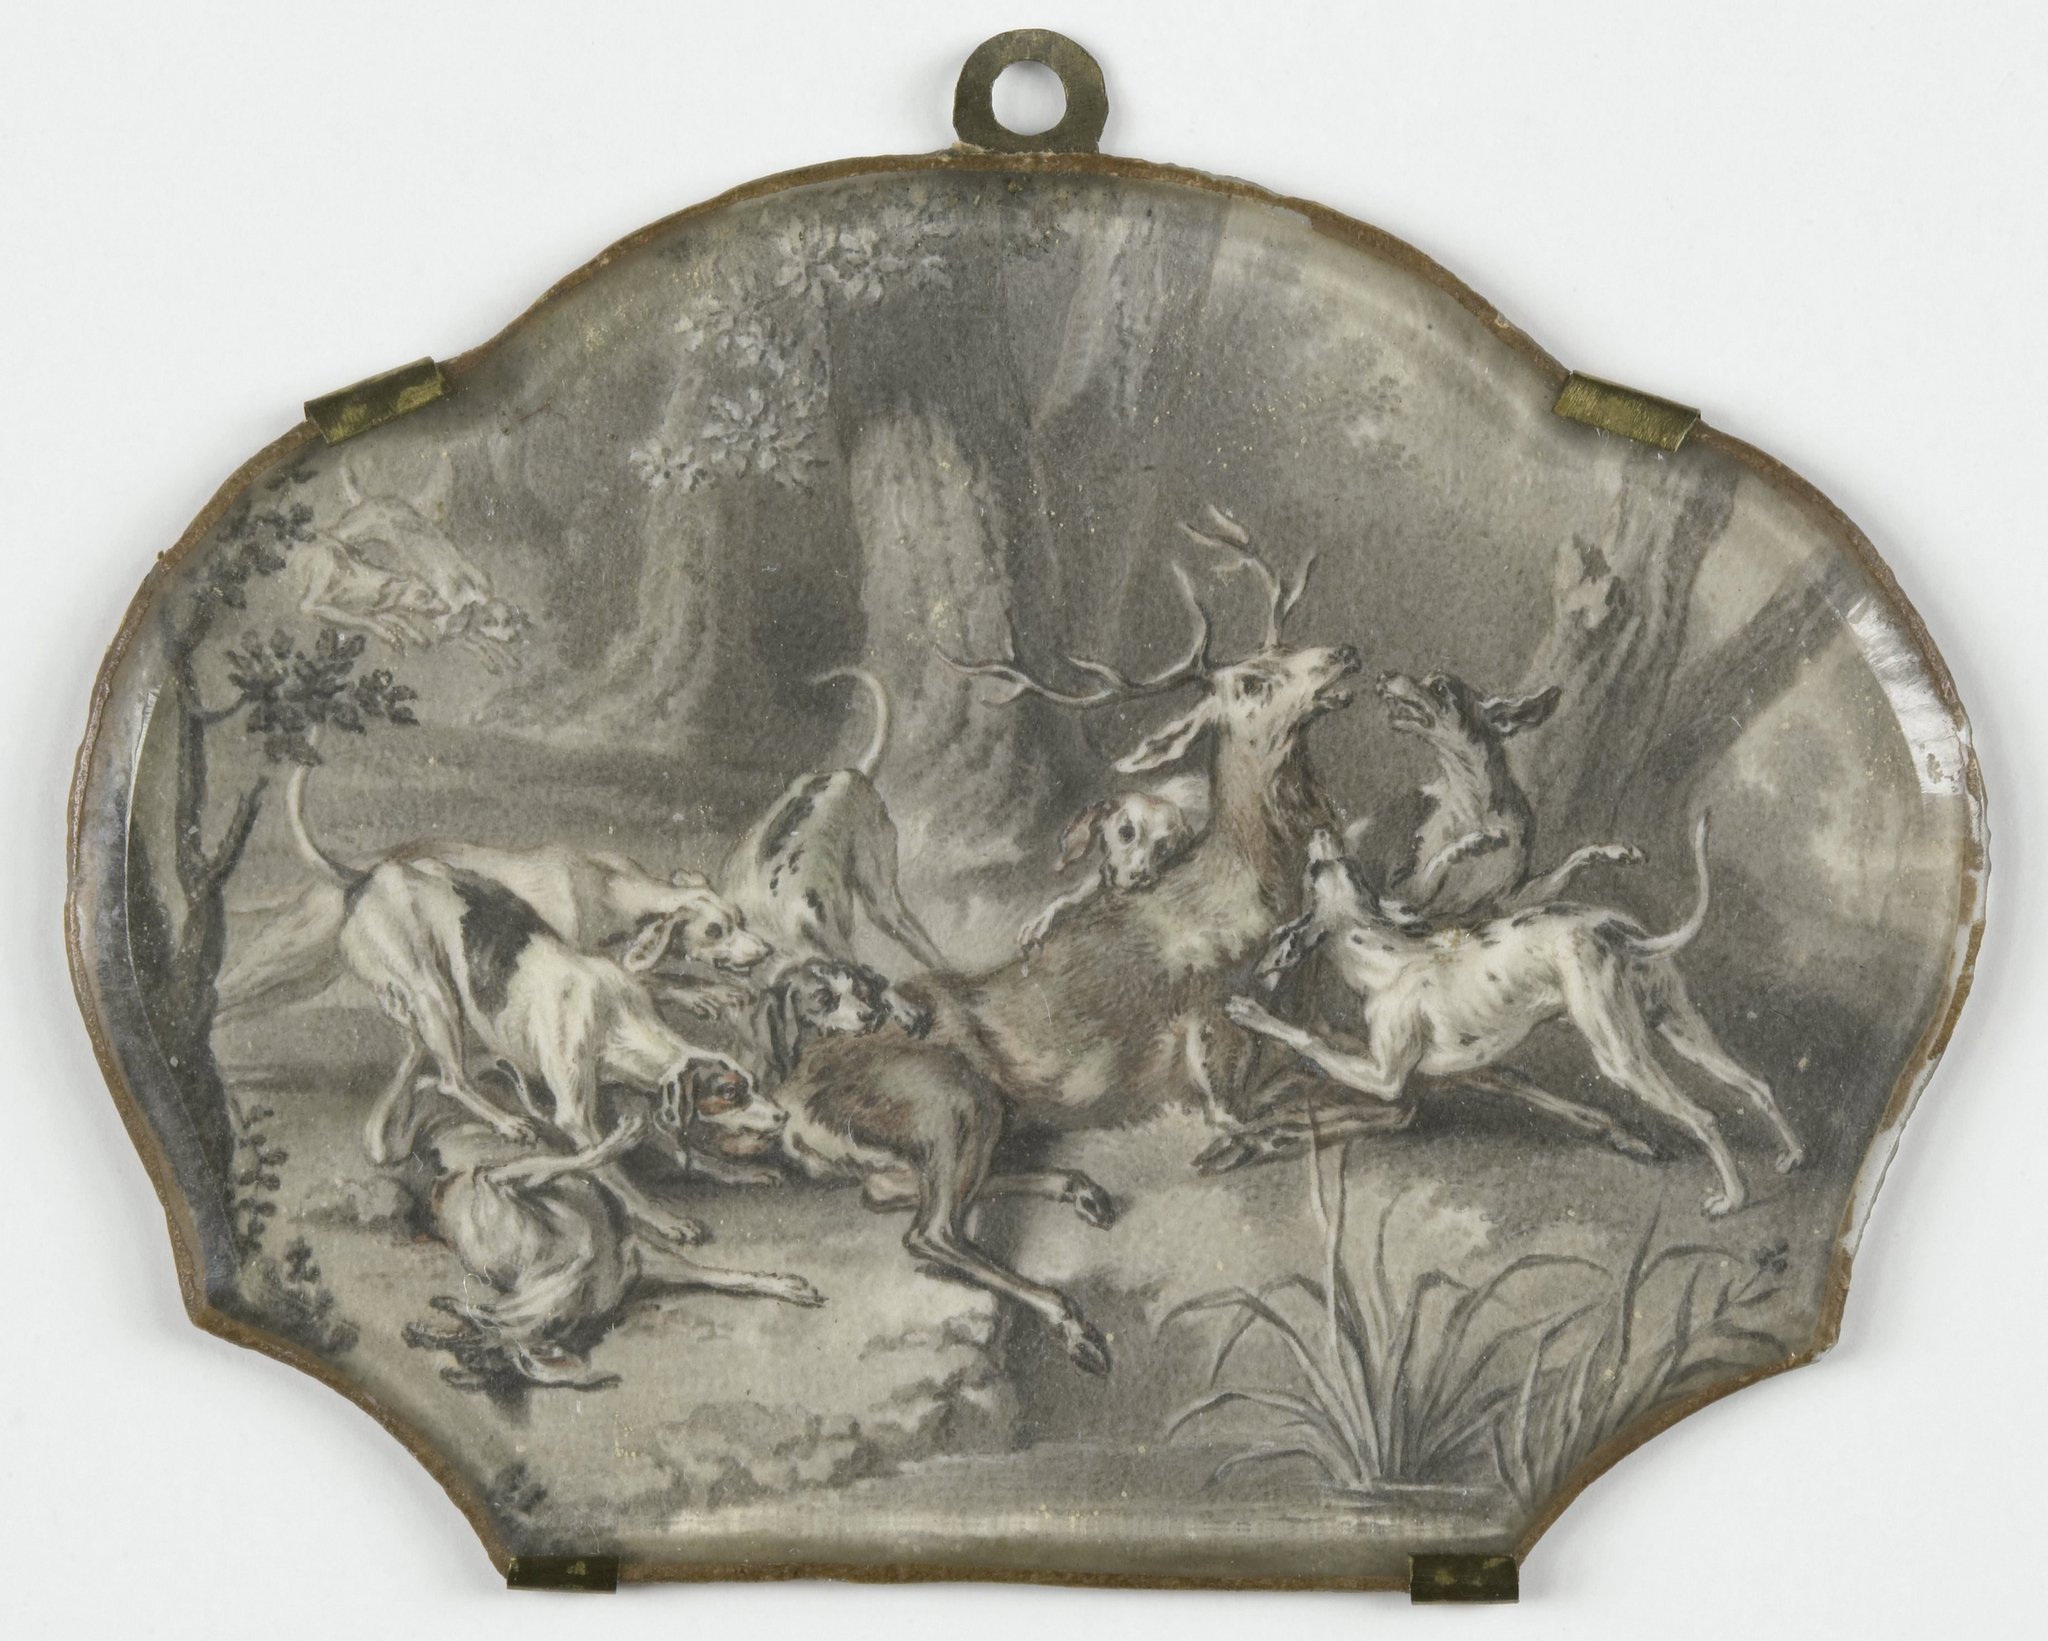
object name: painting, miniature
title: Hertenjacht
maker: Anonymous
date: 1715-1735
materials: cardboard, glass, ink, metal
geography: france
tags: game, hunted animals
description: Hertenjacht. In een bos worden een hert met jong verscheurd door een pak honden. Naar een origineel door Jean Baptiste Oudry. Onderdeel van de collectie miniaturen.